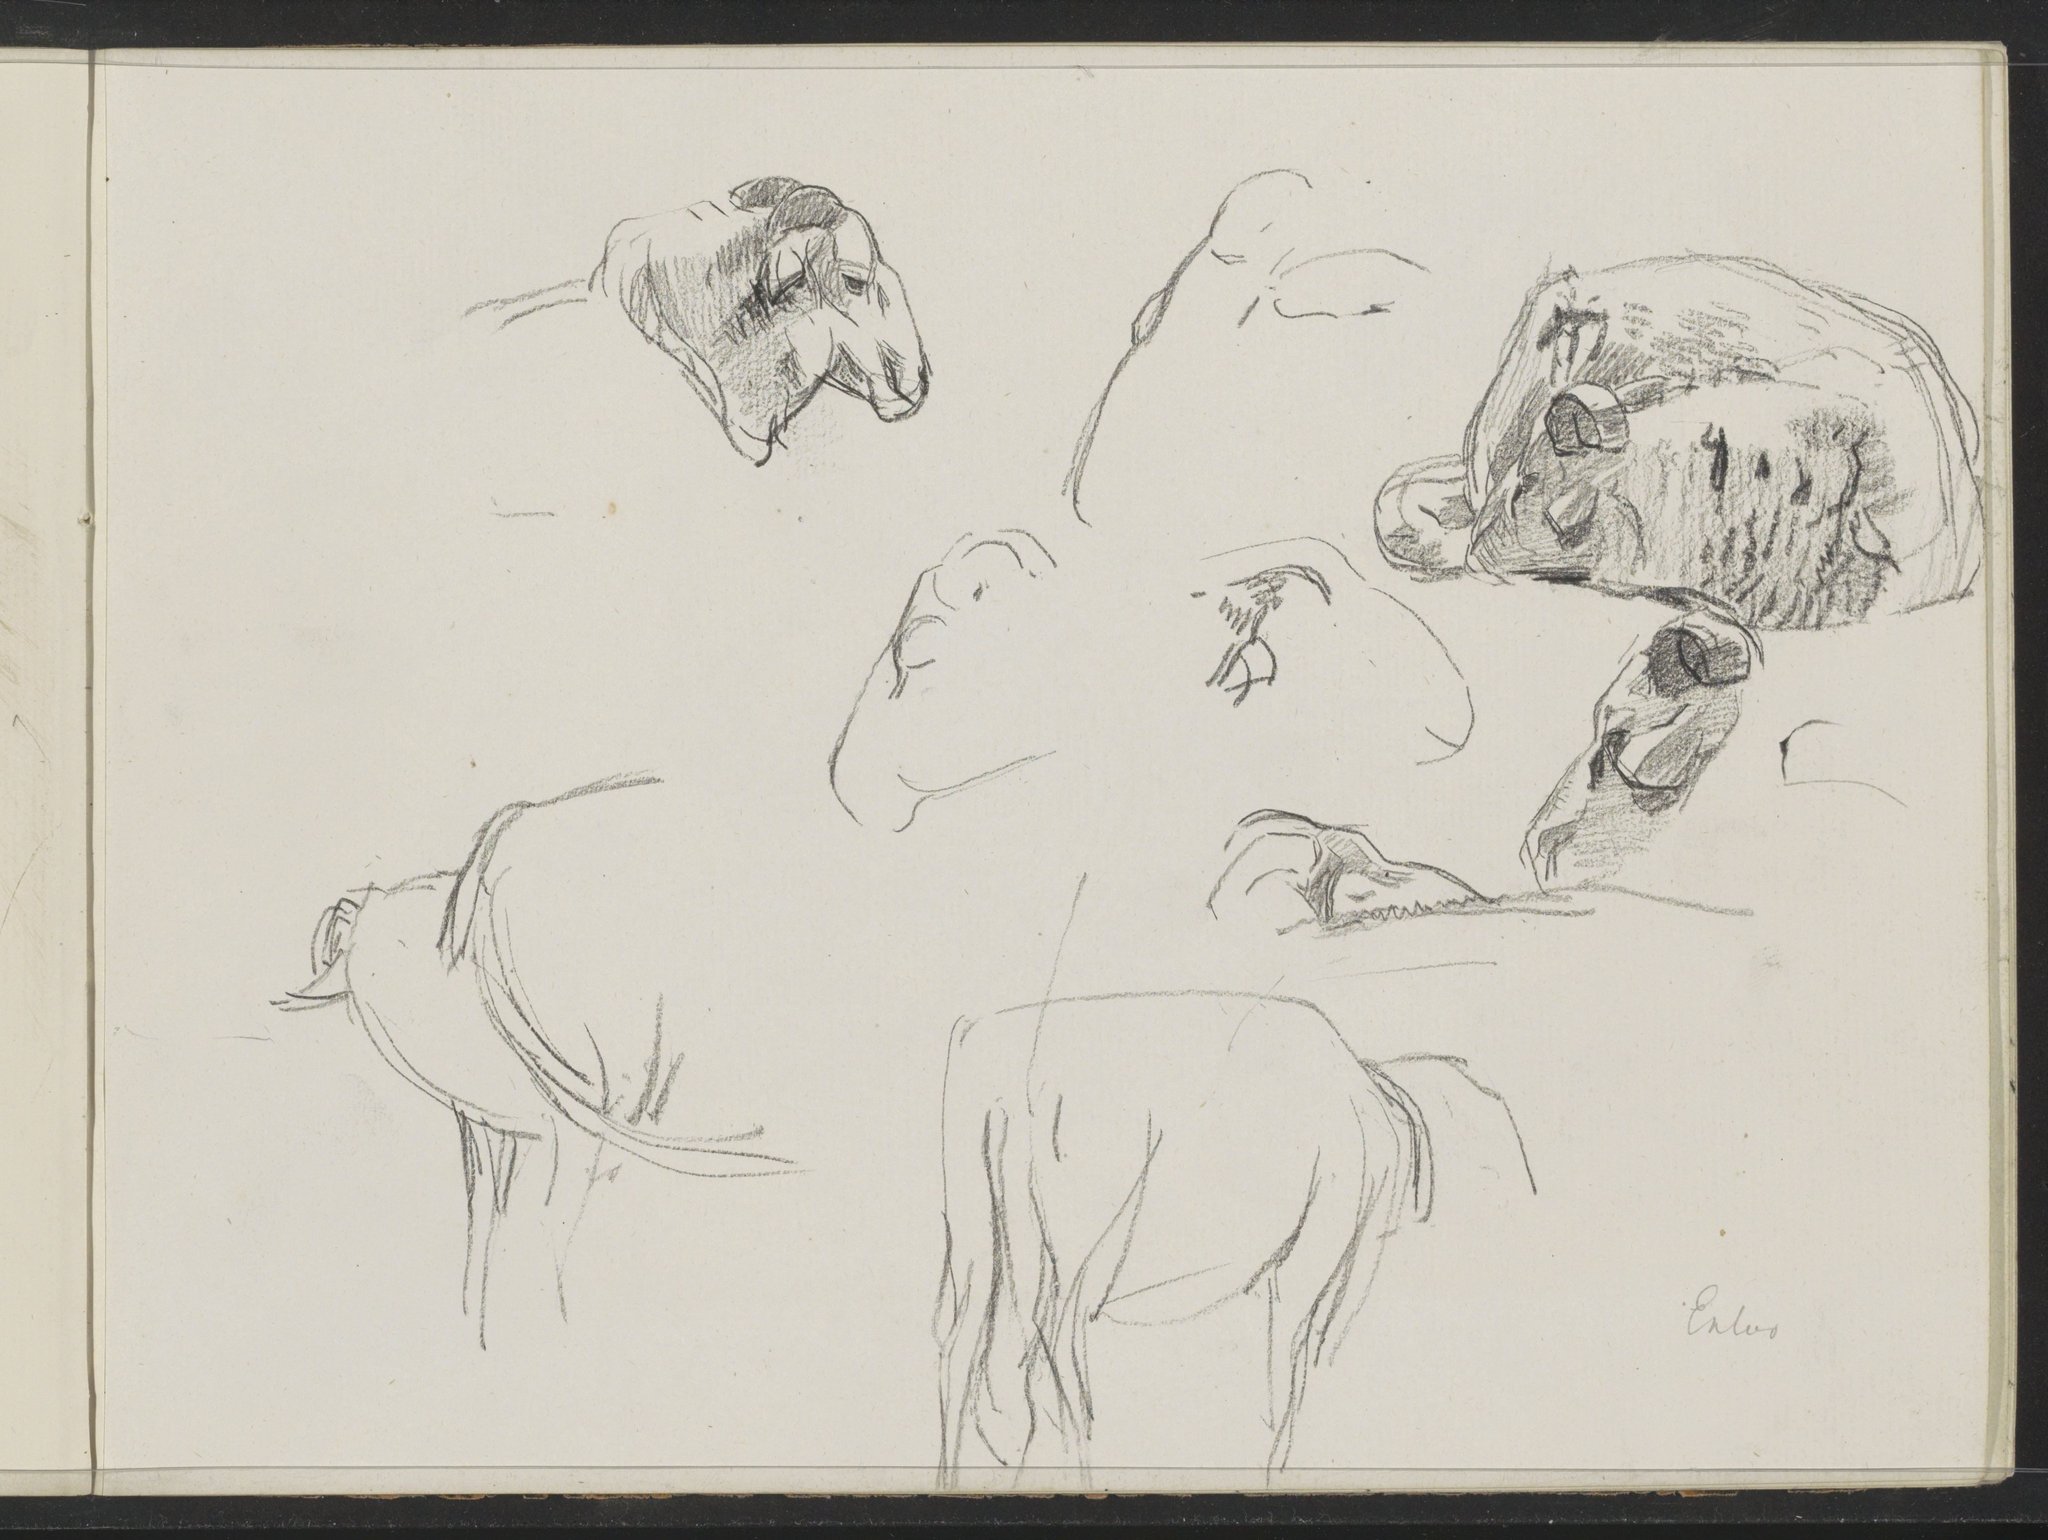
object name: sketchbook leaf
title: Studieblad met schapen te Exloo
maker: ferdinand oldewelt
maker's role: draughtsman, print maker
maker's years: 1857-1935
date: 1904-1912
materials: chalk, paper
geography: exloo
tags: sheep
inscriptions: annotation: ‘Exloo’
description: Blad 16 recto uit een schetsboek met 27 bladen.